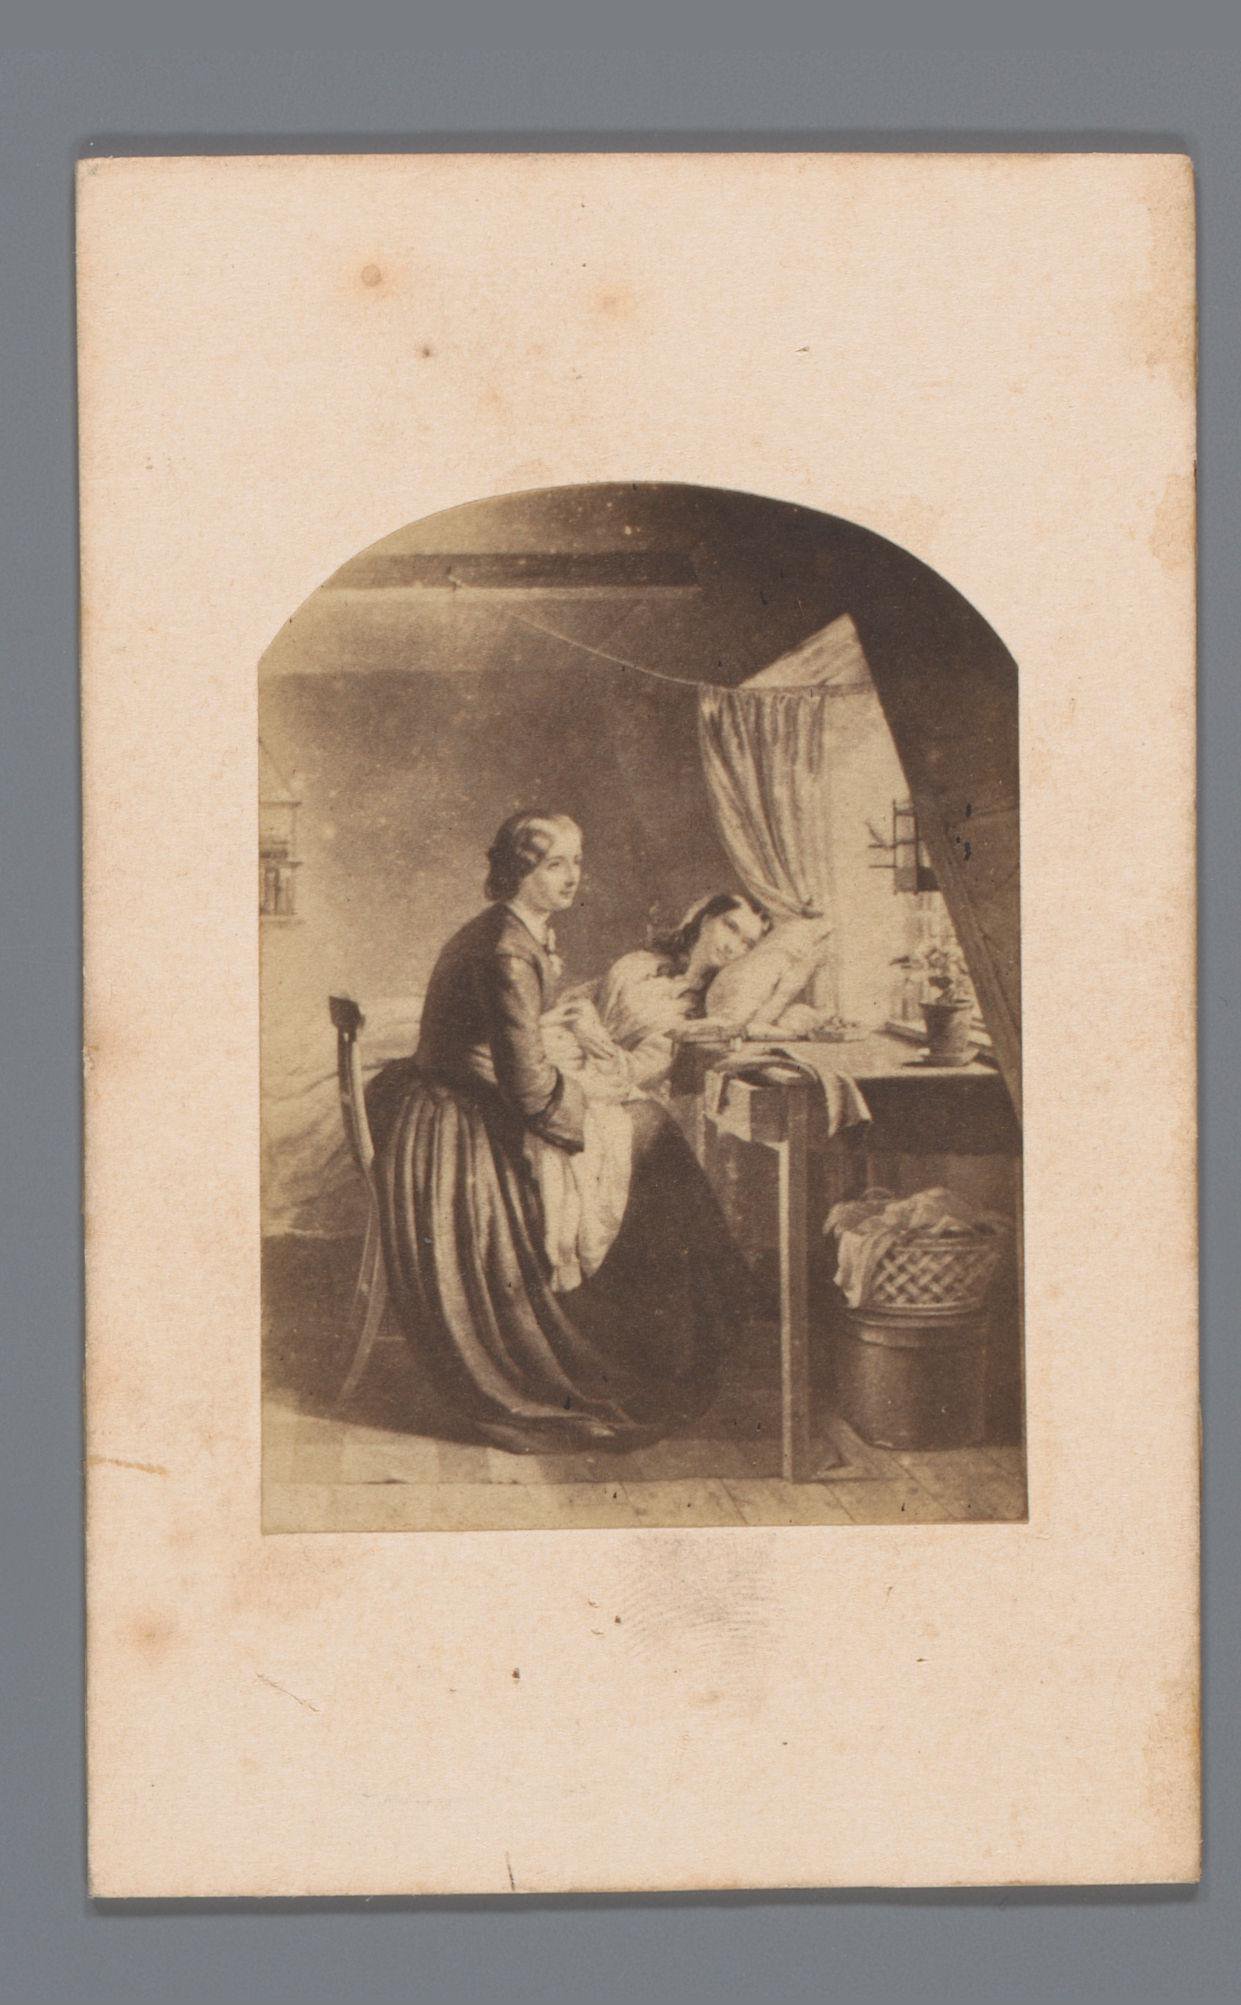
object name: reproduction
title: Fotoreproductie van een tekening van twee jonge vrouwen in een kamer, met achterop het gedicht Vriendschap in Tegenspoed van Ten Kate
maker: Anonymous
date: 1855-1885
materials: cardboard, paper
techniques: albumen print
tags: adolescent, young woman, maiden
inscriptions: inscription: ‘Vriendschap in tegenspoed./ Zoet kwinkeleert het vogelkijn, (...) Maar trouw die van geen wanklen weet,/ Begroet ik als Gods beeld./ J.J.L. ten Kate’